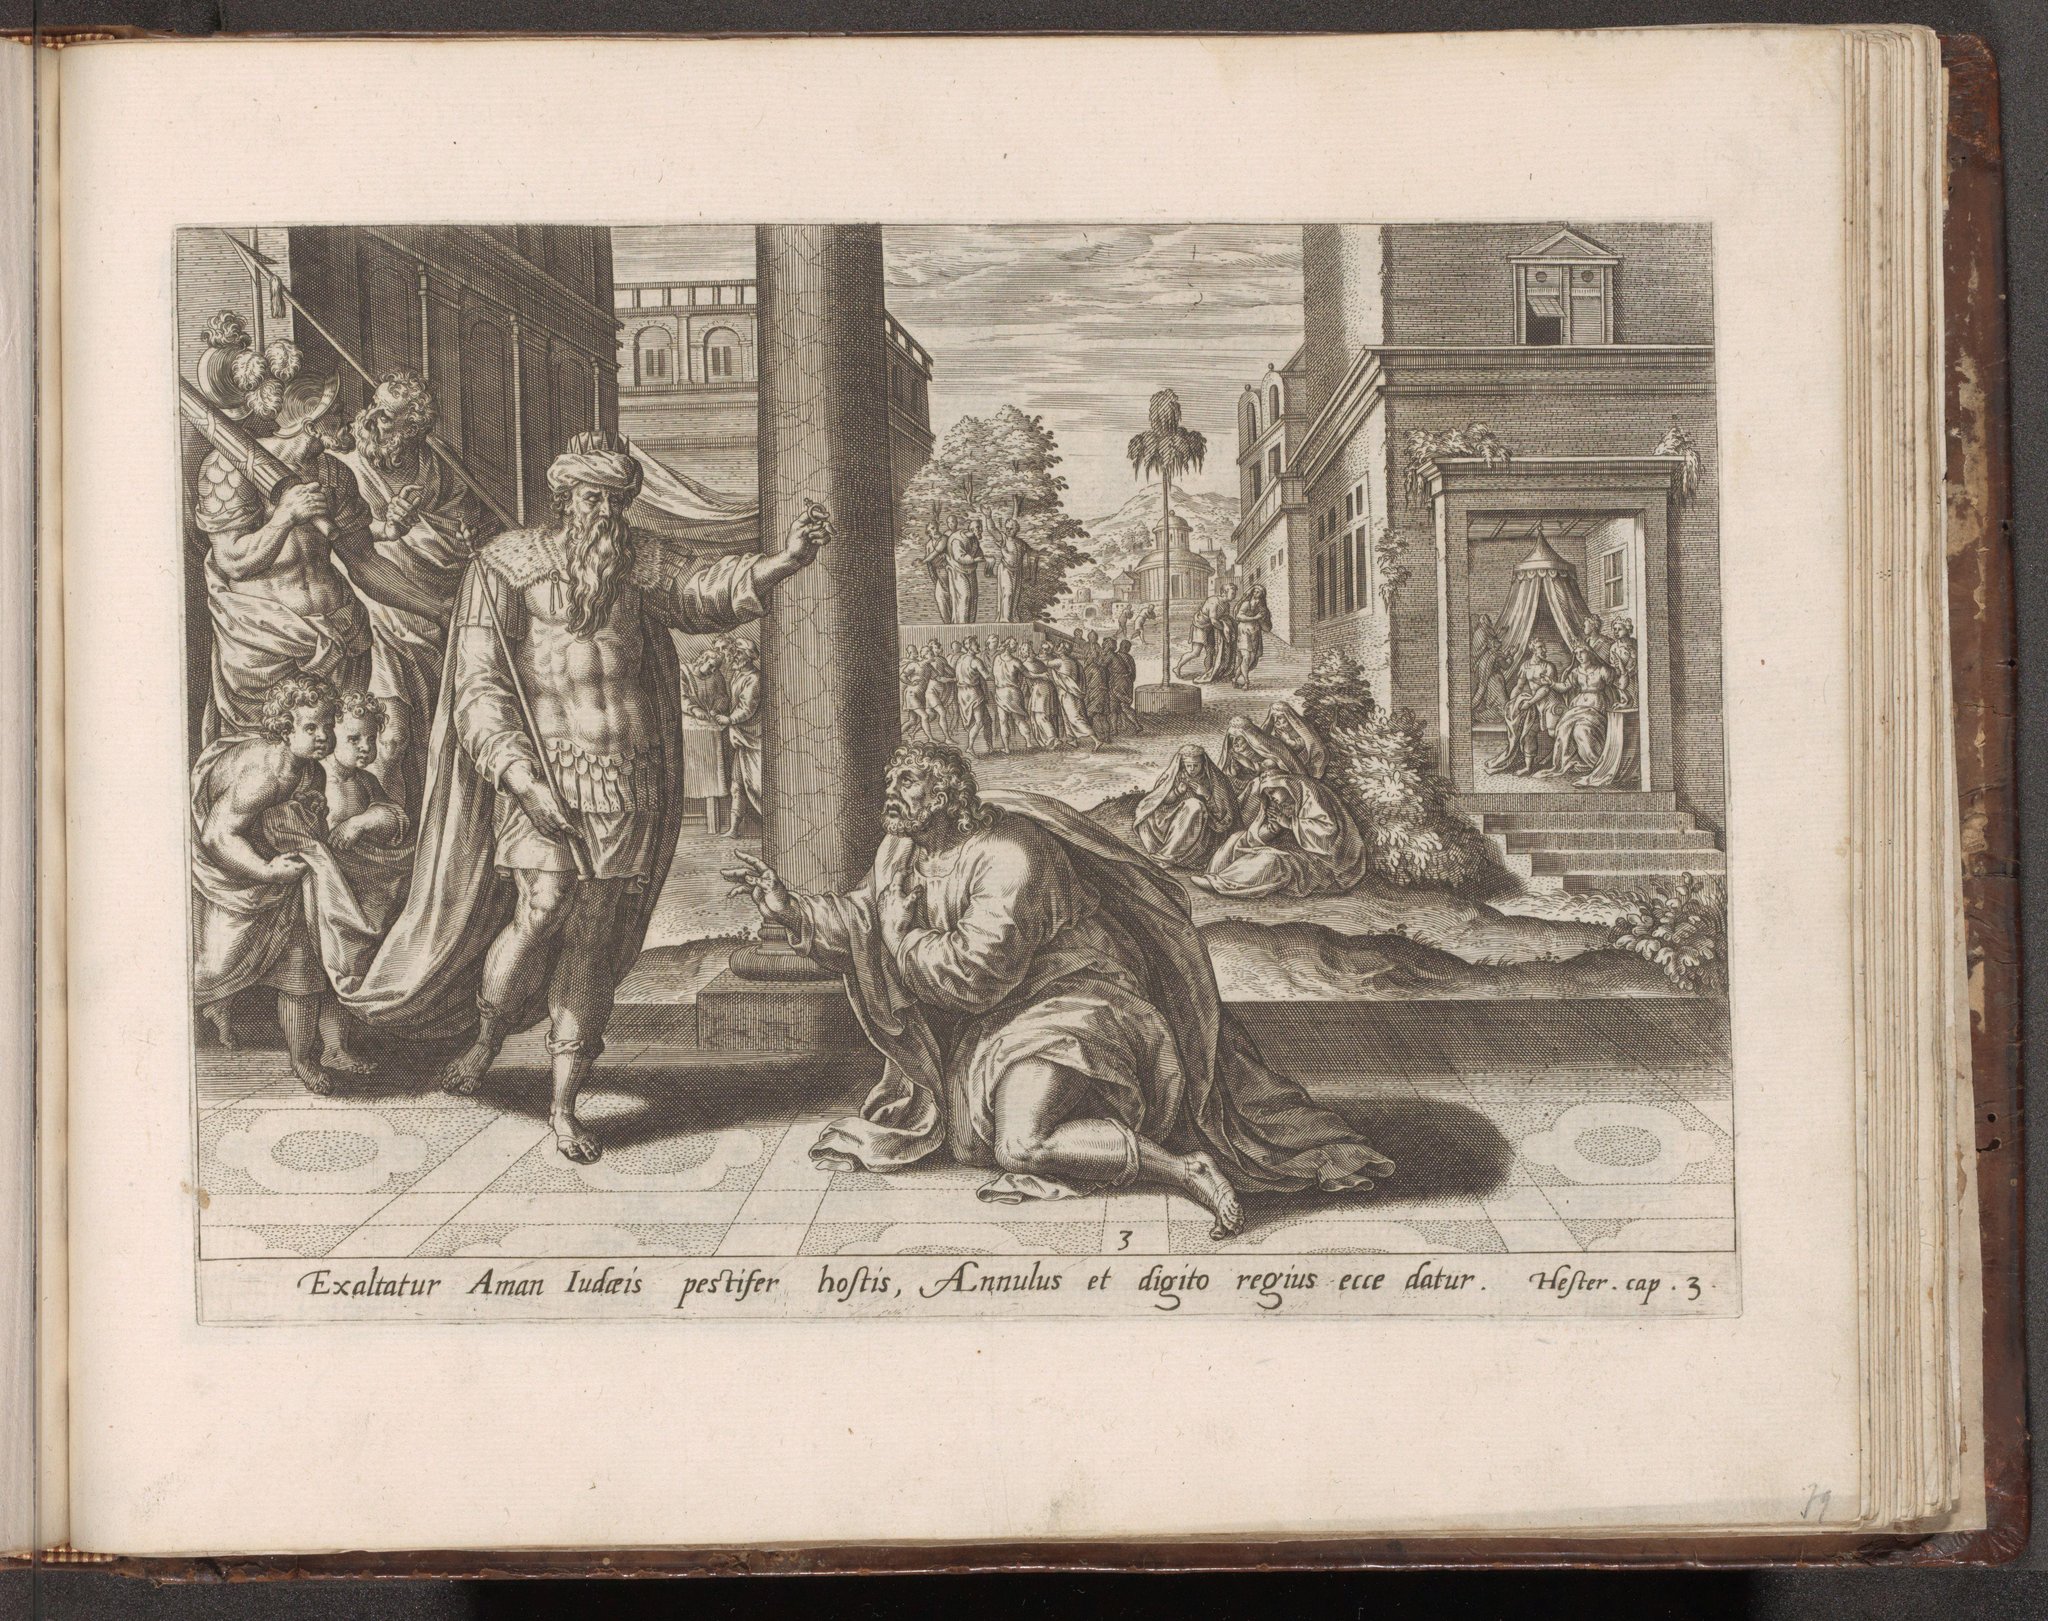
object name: print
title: Geschiedenis van Ester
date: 1579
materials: paper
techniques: engraving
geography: antwerp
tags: mourning, prayer and distress of esther (esther 14), the jews mourn throughout the kingdom, a royal decree is issued and sent throughout the country ~ haman's plot against the jews, haman entreats ahasuerus to issue a decree that all the jews are to be put to death; ahasuerus consents and yields his signet-ring to haman, esther sends mordecai some clothes; he refuses them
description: Koning Ahasveros geeft zijn zegelring aan Haman, waarmee Haman uit naam van de koning zijn plan kan laten uitvoeren om alle Joden ter dood te laten brengen. Op de achtergrond wordt het besluit verkondigd. Een groepje Joden zit te treuren met as op het hoofd. Rechts koningin Ester in haar vertrek waar ze een dienaar de opdracht geeft om Mordechai kleren te brengen zodat hij die kan dragen in plaats van zijn rouwkleed. Links naast het gebouw weigert Mordechai de kleren te aanvaarden. Nog verder op de achtergrond bidt Ester om een goede afloop. Onder de voorstelling een verwijzing in het Latijn naar de Bijbeltekst in Est. 3. Prent maakt deel uit van een album.